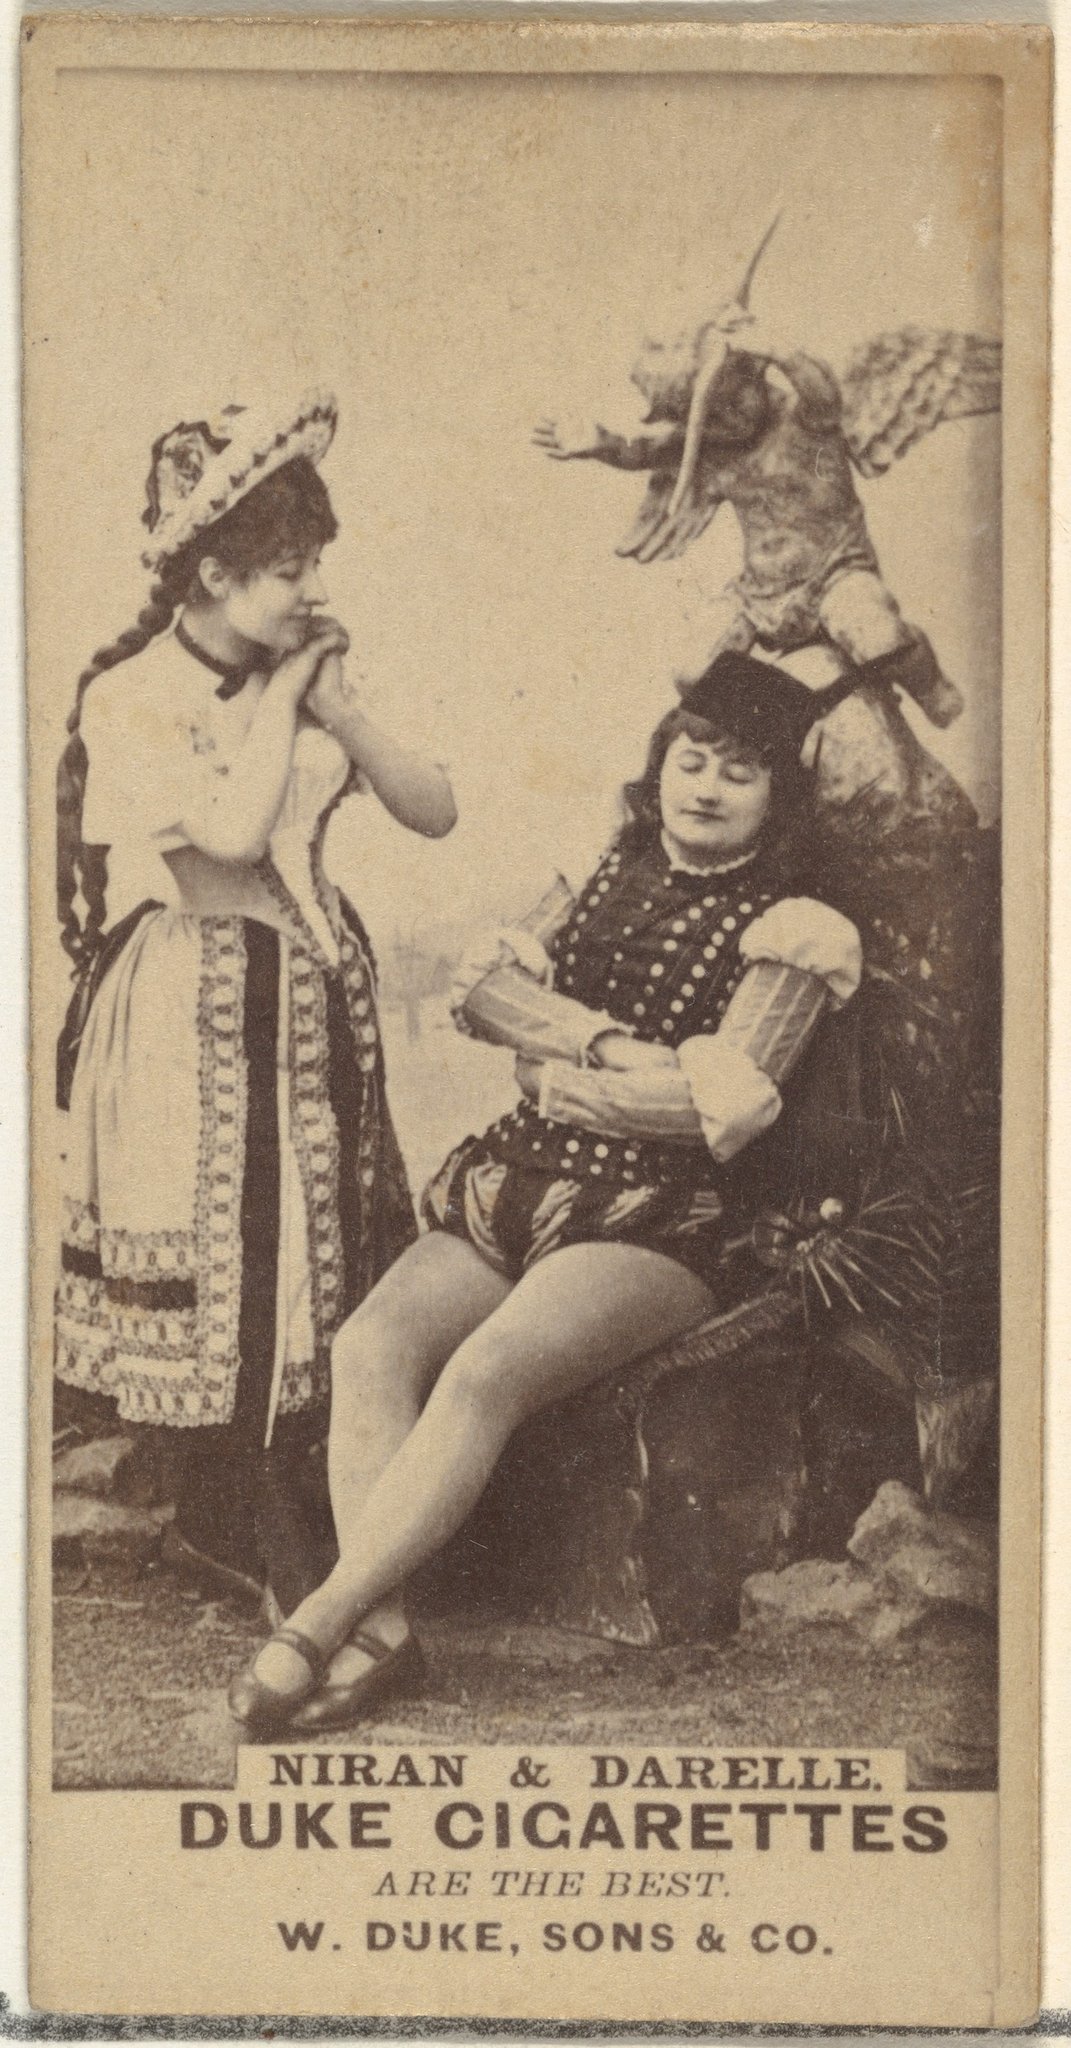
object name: photograph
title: Niran & Darelle, from the Actors and Actresses series (N145-7) issued by Duke Sons & Co. to promote Duke Cigarettes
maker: w. duke, sons & co.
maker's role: publisher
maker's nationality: american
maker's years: 1870-1920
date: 1880-1889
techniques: albumen silver print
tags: portraits,women,actresses